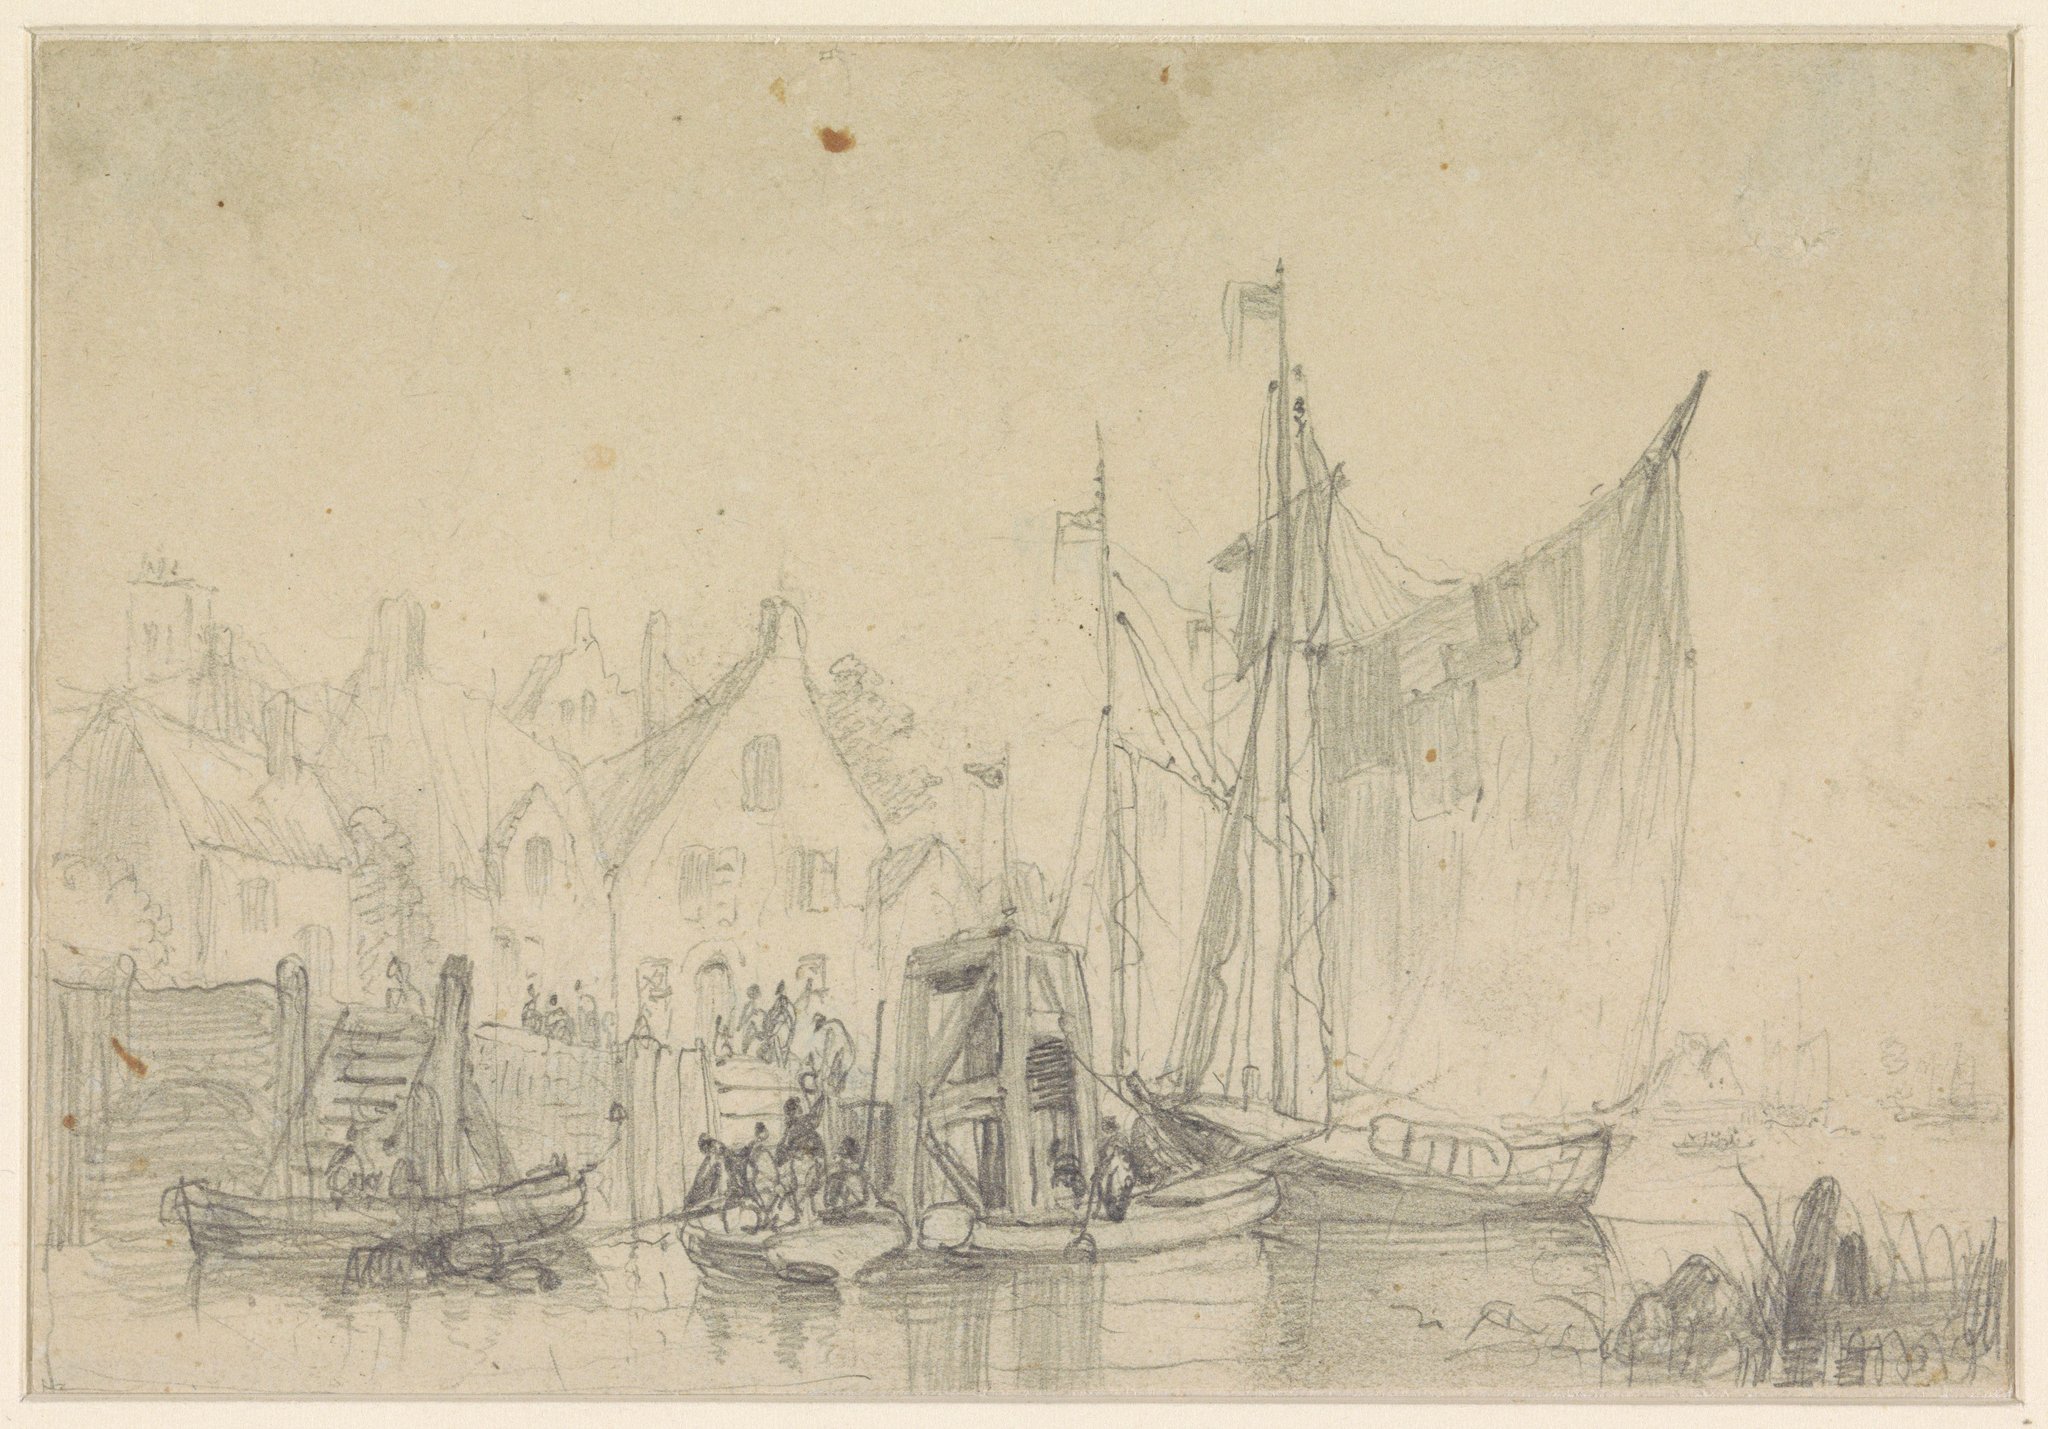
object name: drawing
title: Het vertrek van boten uit een dorp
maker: henri adolphe schaep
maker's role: draughtsman, painter, print maker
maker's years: 1826-1870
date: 1856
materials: paper, pencil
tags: harbour, quay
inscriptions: date: ‘1856’